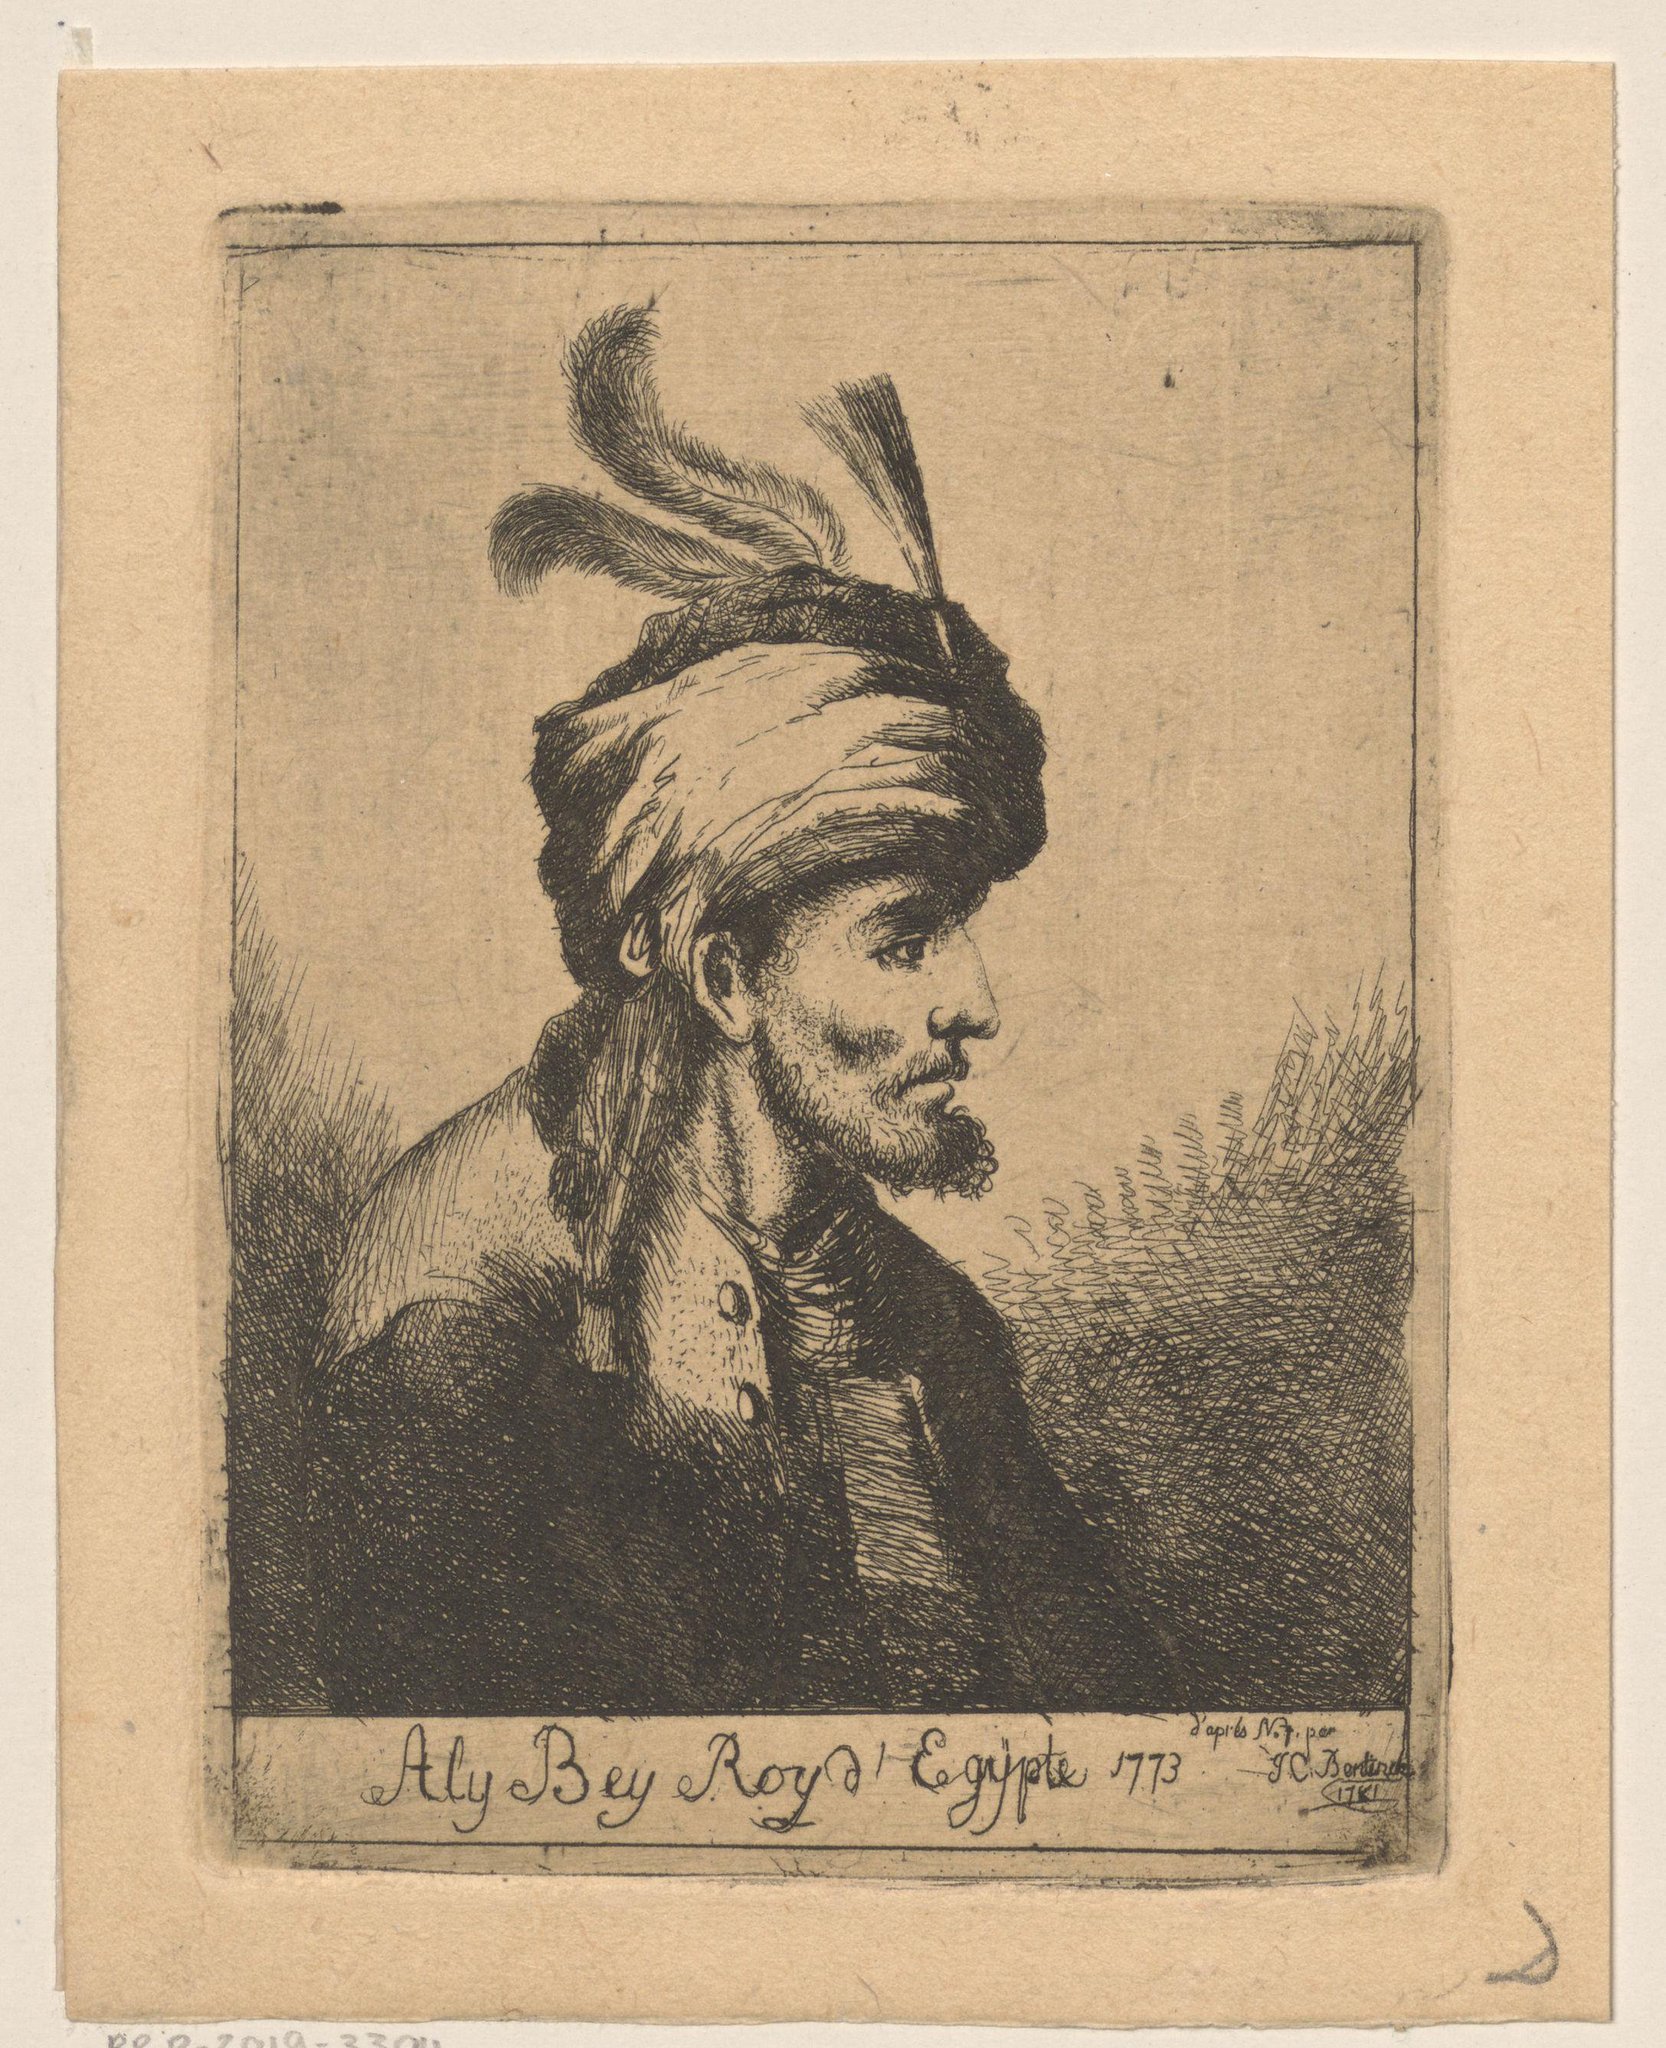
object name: print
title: Portret van Ali Bey al-Kabir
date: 1781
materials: paper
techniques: drypoint, etching, intaglio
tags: historical persons, head-gear: turban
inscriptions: collector's mark: Lugt 698, collector's mark: Lugt 2228